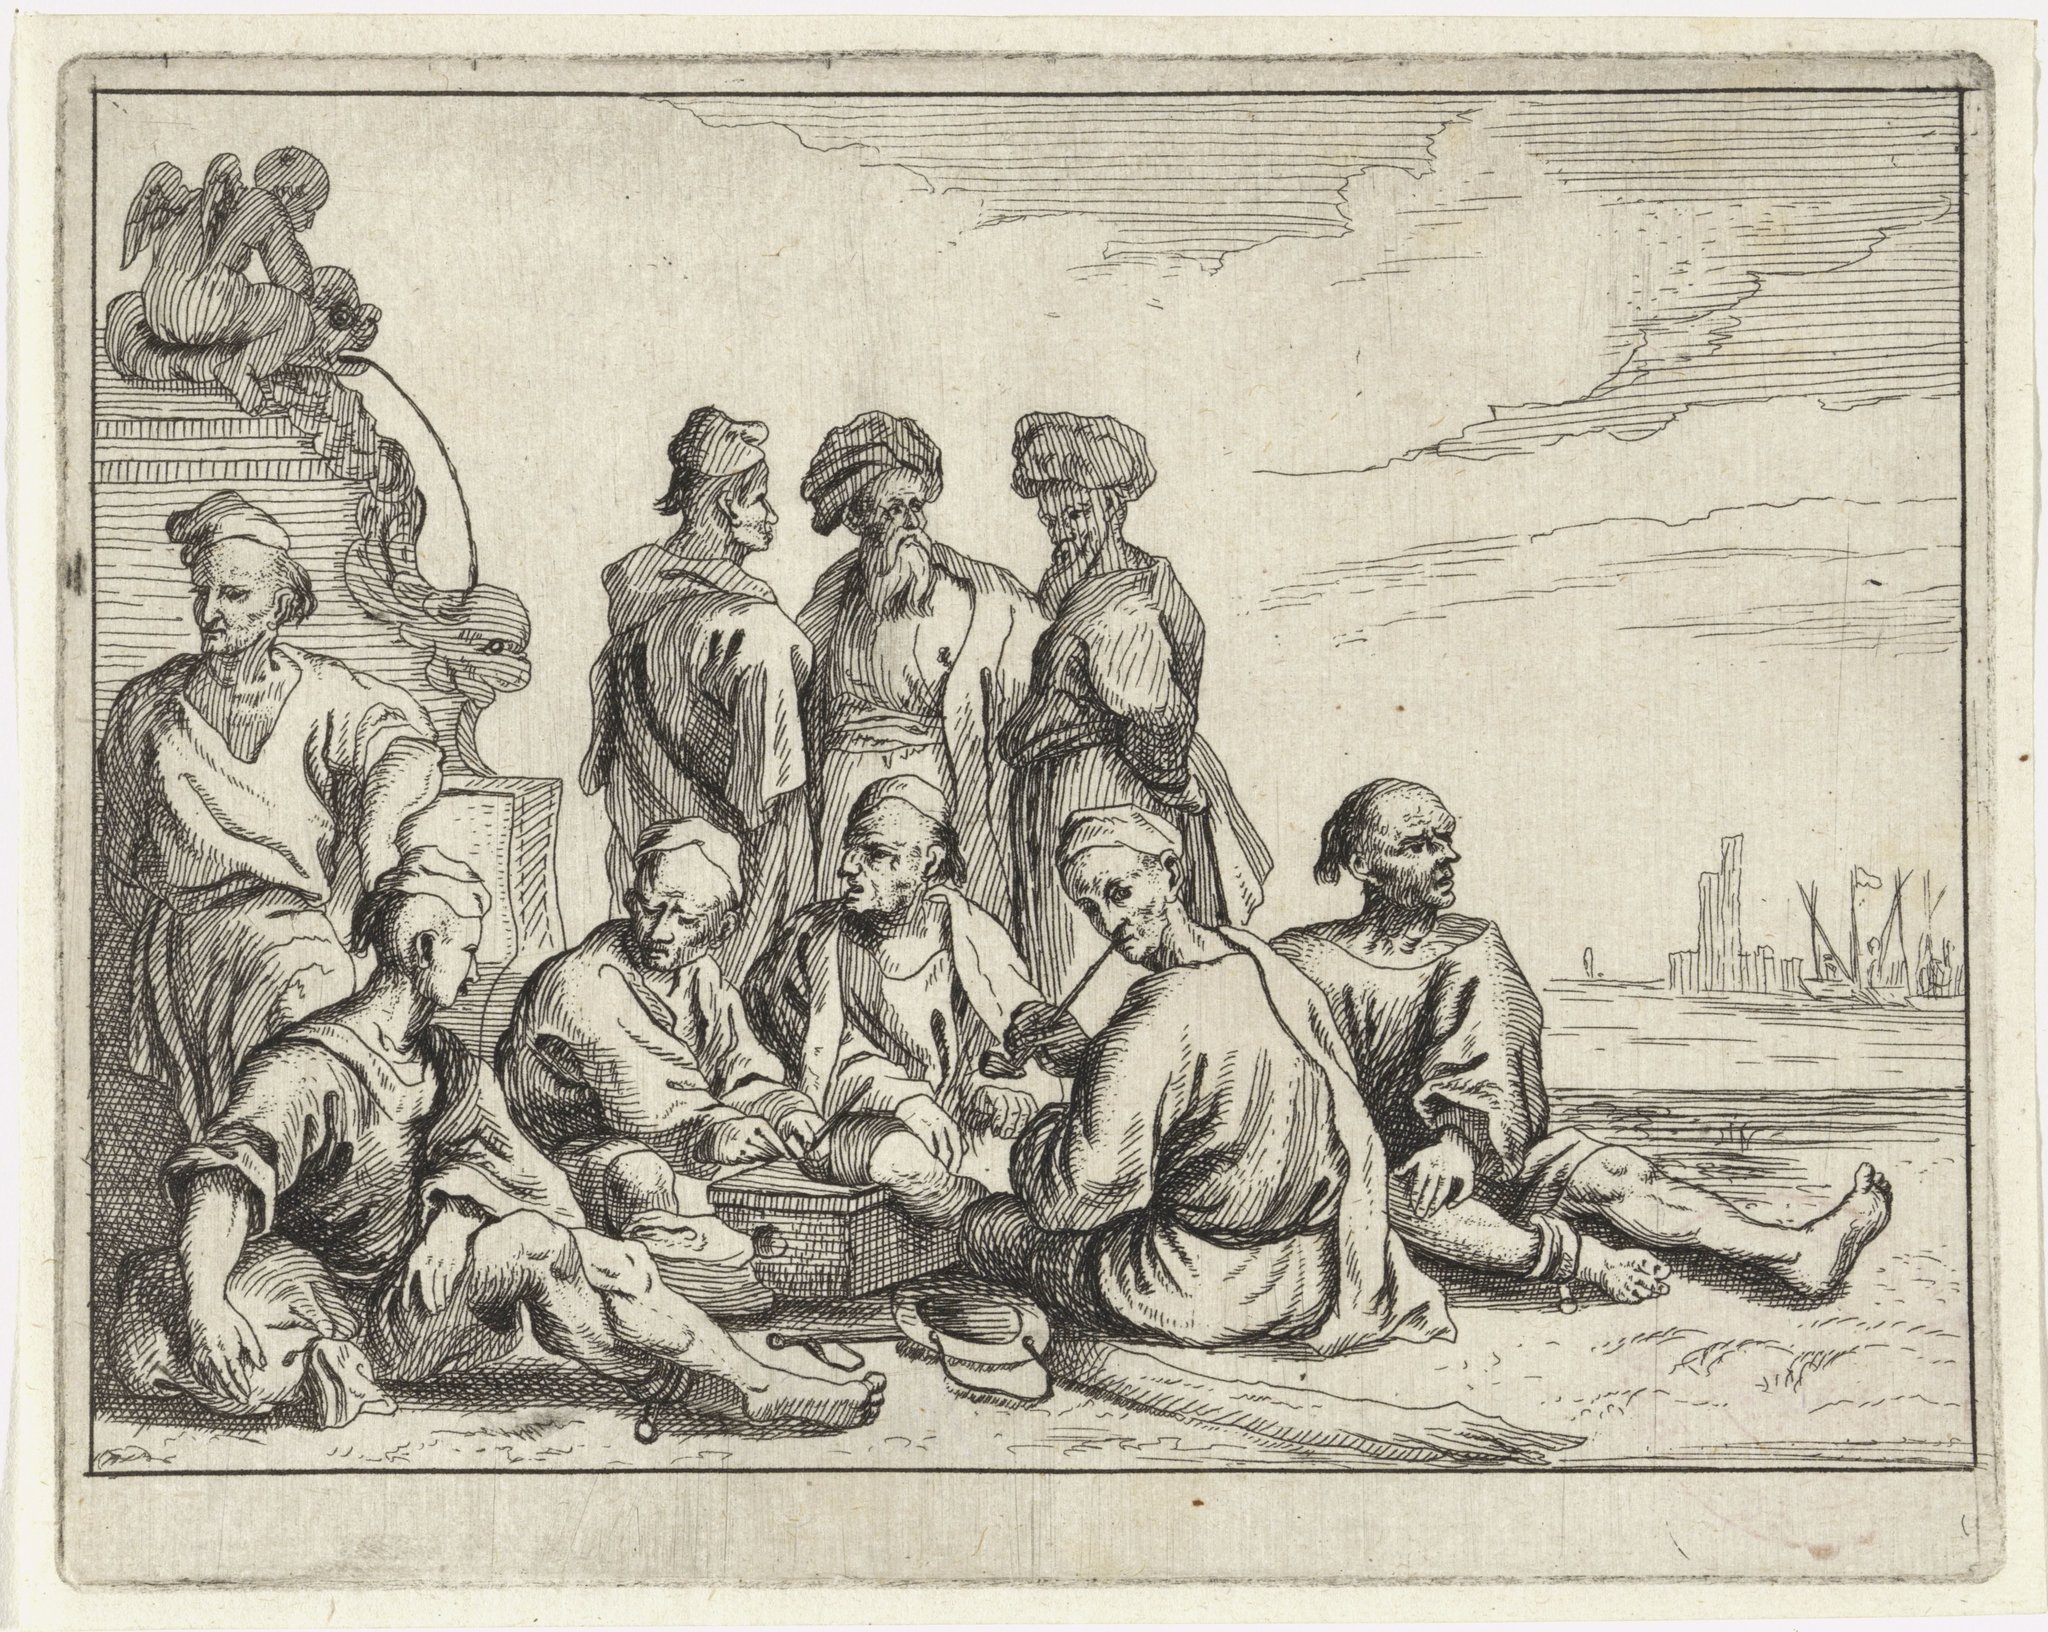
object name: print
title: Haventaferelen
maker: m. schaep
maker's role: print maker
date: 1649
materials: paper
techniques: etching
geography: northern netherlands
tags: harbour, slavery; serfs and enslaved persons, ornamental fountain, seaman: sailor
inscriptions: collector's mark: Lugt 240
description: Islamitische galeislaven rusten bij een fontein. Eén van hen rookt een pijp. Deze tot slaaf gemaakte mannen zijn als moslims te herkennen door het typerende kapsel (hoofd op een pluk na kaalgeschoren) dat zij verplicht waren te hebben. De staande mannen met tulband zijn waarschijnlijk papassi (moellahs en vertegenwoordigers van de islamitische tot slaaf gemaakten). Rechtssachter enkele schepen in het water.